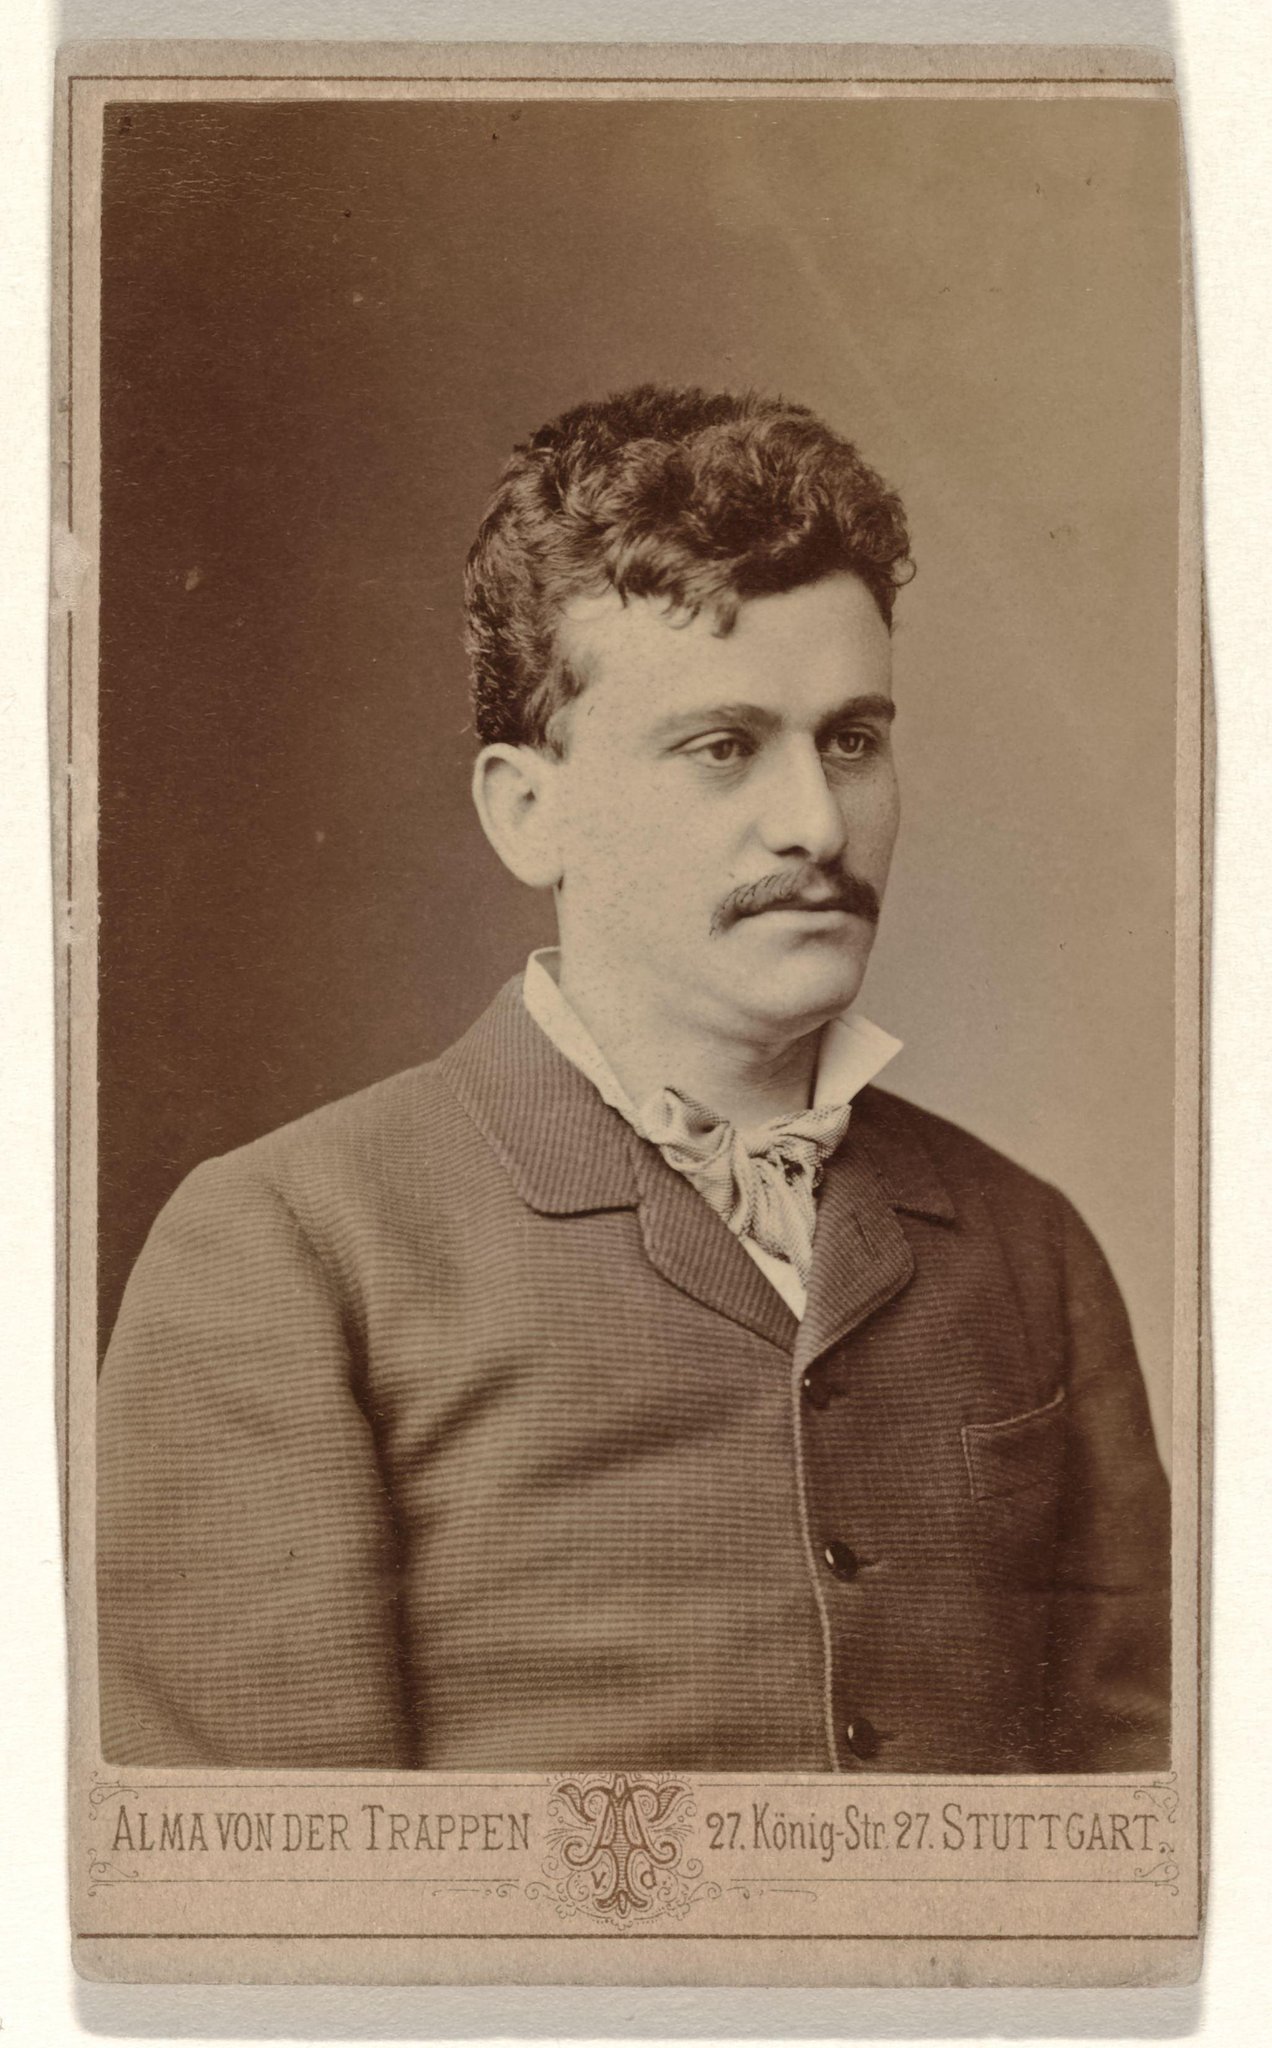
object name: photograph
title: Portret van een onbekende man, mogelijk Meir Wachenheimer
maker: alma von der trappen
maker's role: fotograaf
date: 1870-1920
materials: photographic support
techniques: gelatin silver print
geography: stuttgart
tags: straatsburg (frankrijk)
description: Portret van een onbekende man met snor, dichte witte boord en bovenkleed met twee sluitknopen